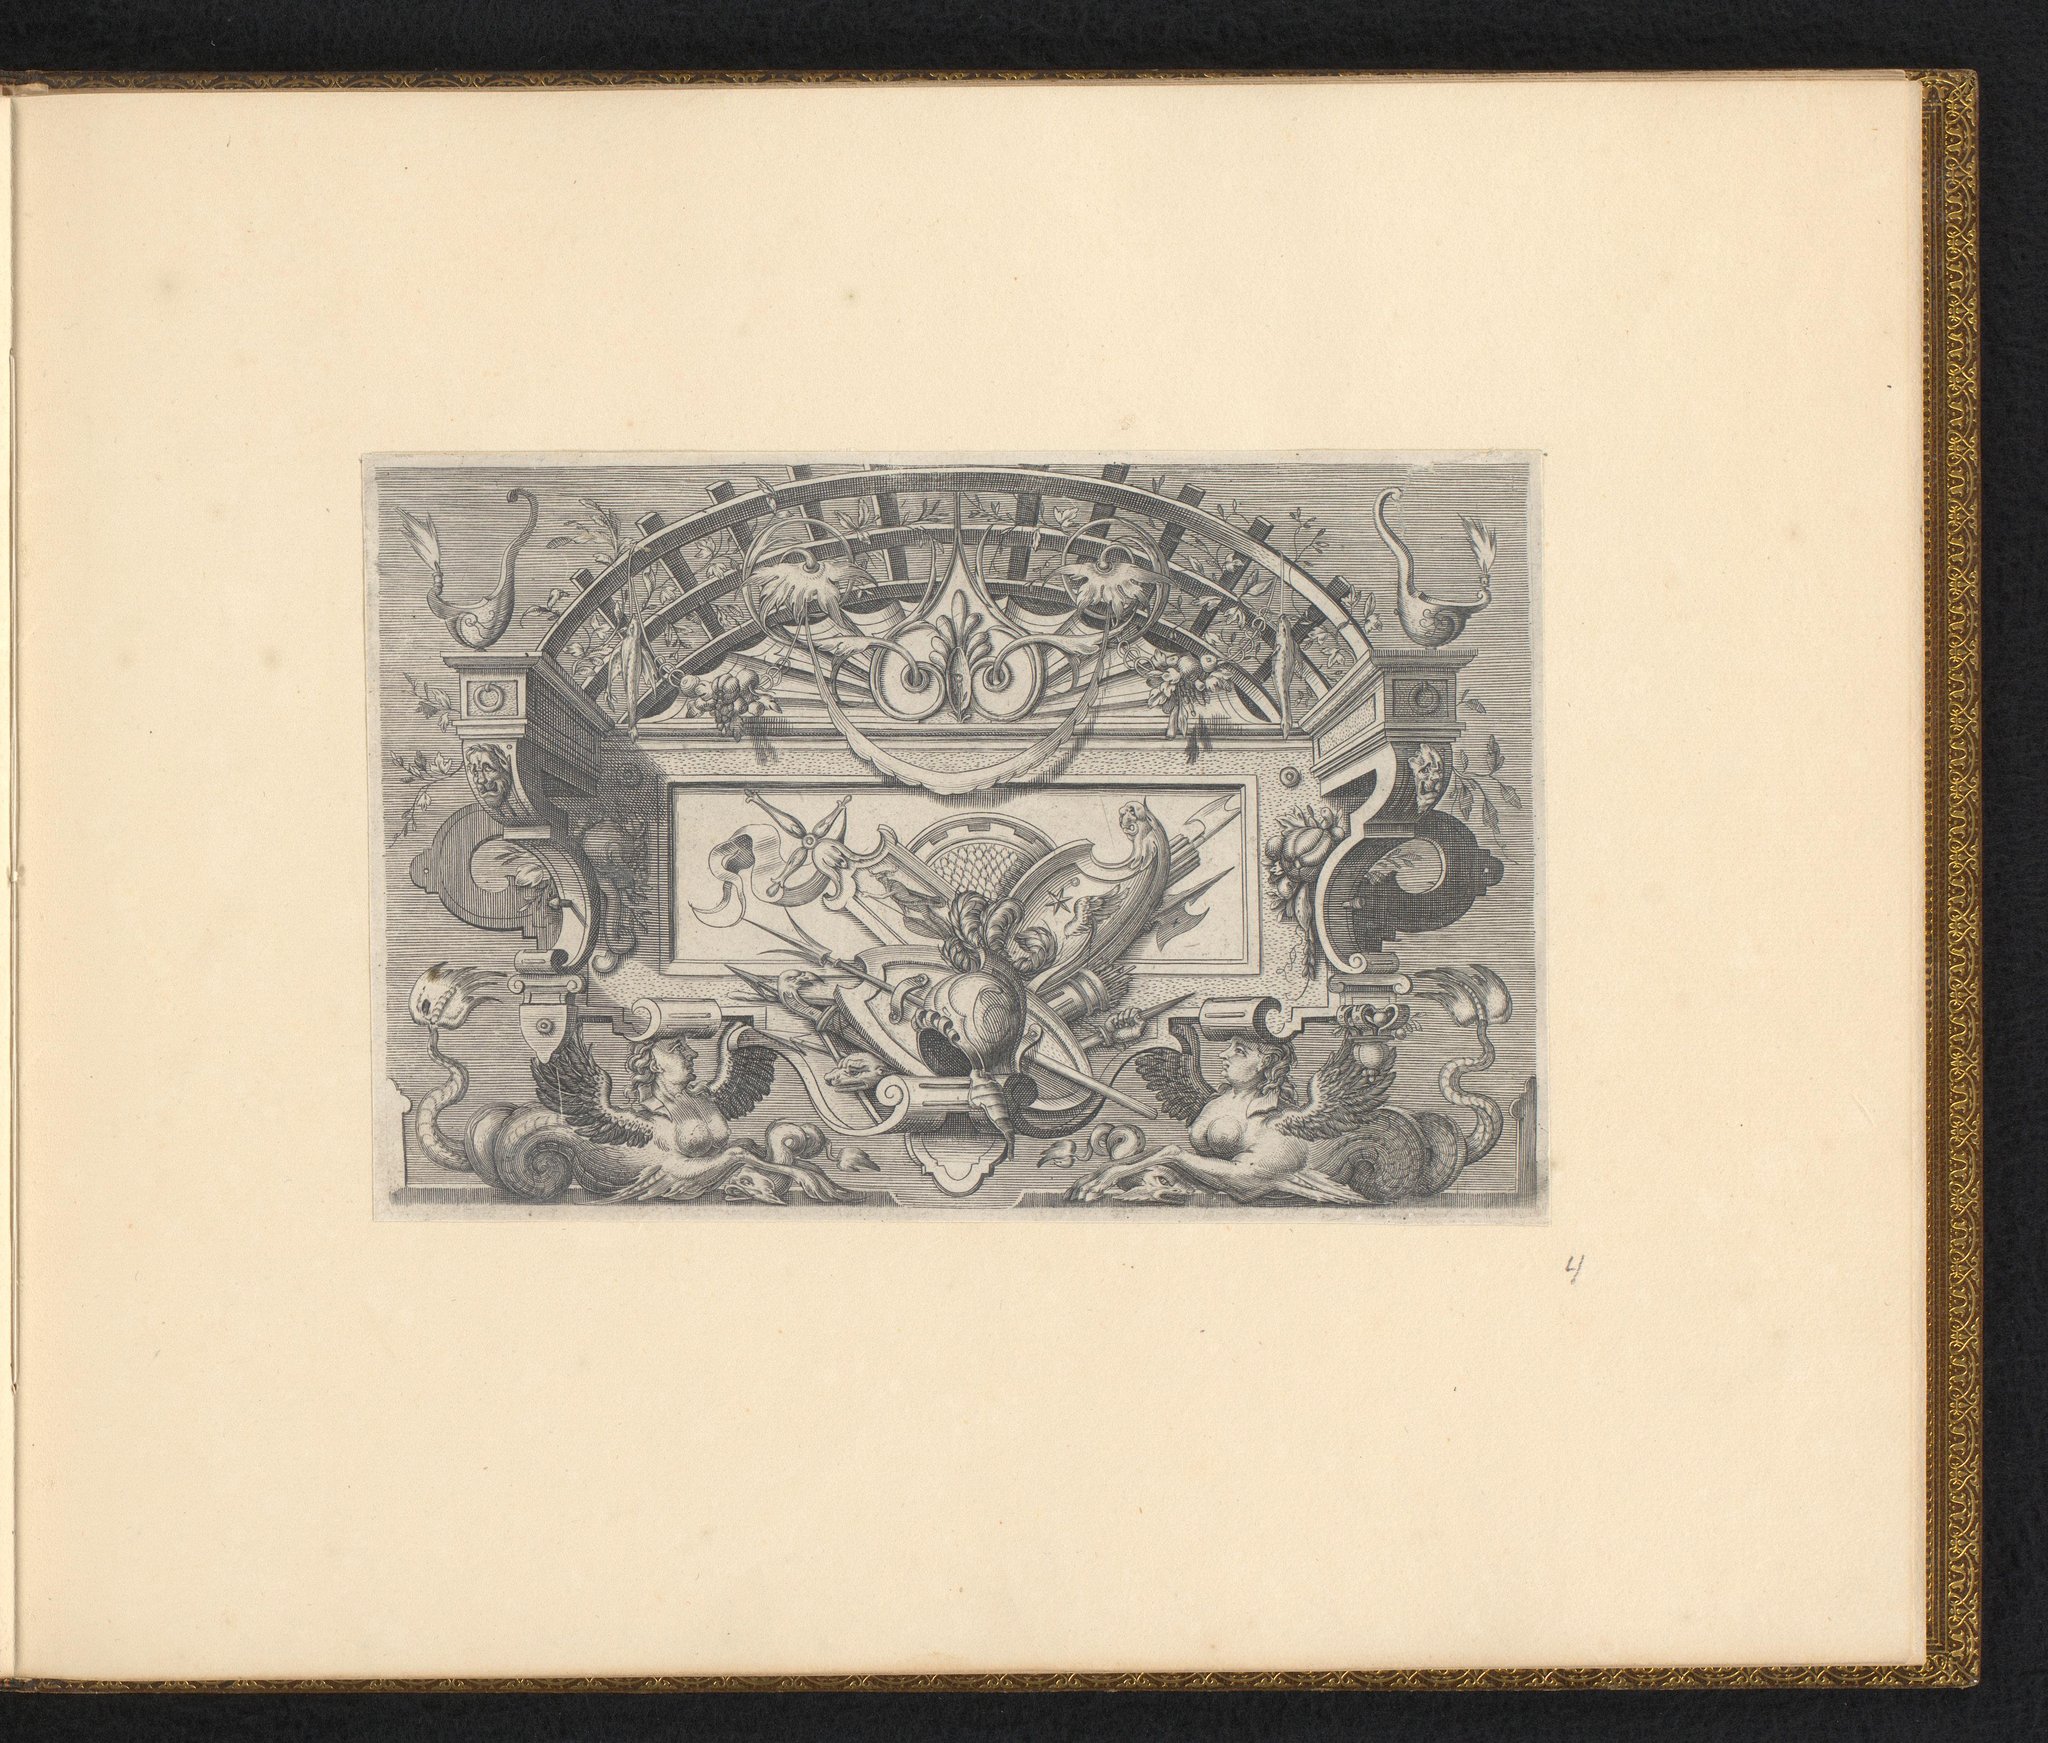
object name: album leaf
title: Cartouche in een omlijsting van rolwerk, met een wapentrofee en twee sfinxen met vissenstaarten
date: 1564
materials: paper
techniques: engraving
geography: amsterdam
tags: sphinx (lion/woman); 'sfinge' (ripa) - aa - female human figure, fabulous animals (sometimes wrongly called 'grotesques'); 'mostri' (ripa), 'tropaion', i.e. decorative ornament ~ weapons, scrollwork, strapwork ~ ornament, fishes, pergola, oil-lamp, ornament ~ cartouche, ornament ~ festoon, garland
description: Cartouche in een omlijsting van rolwerk. Bovenaan een pergola rustend op twee consoles. Links- en rechtsboven een olielamp. Onderaan een wapentrofee. De cartouche rust op de hoofden van twee sfinxen met vissenstaarten, die ieder een vis tussen de voorpoten hebben. De prent maakt deel uit van een album.